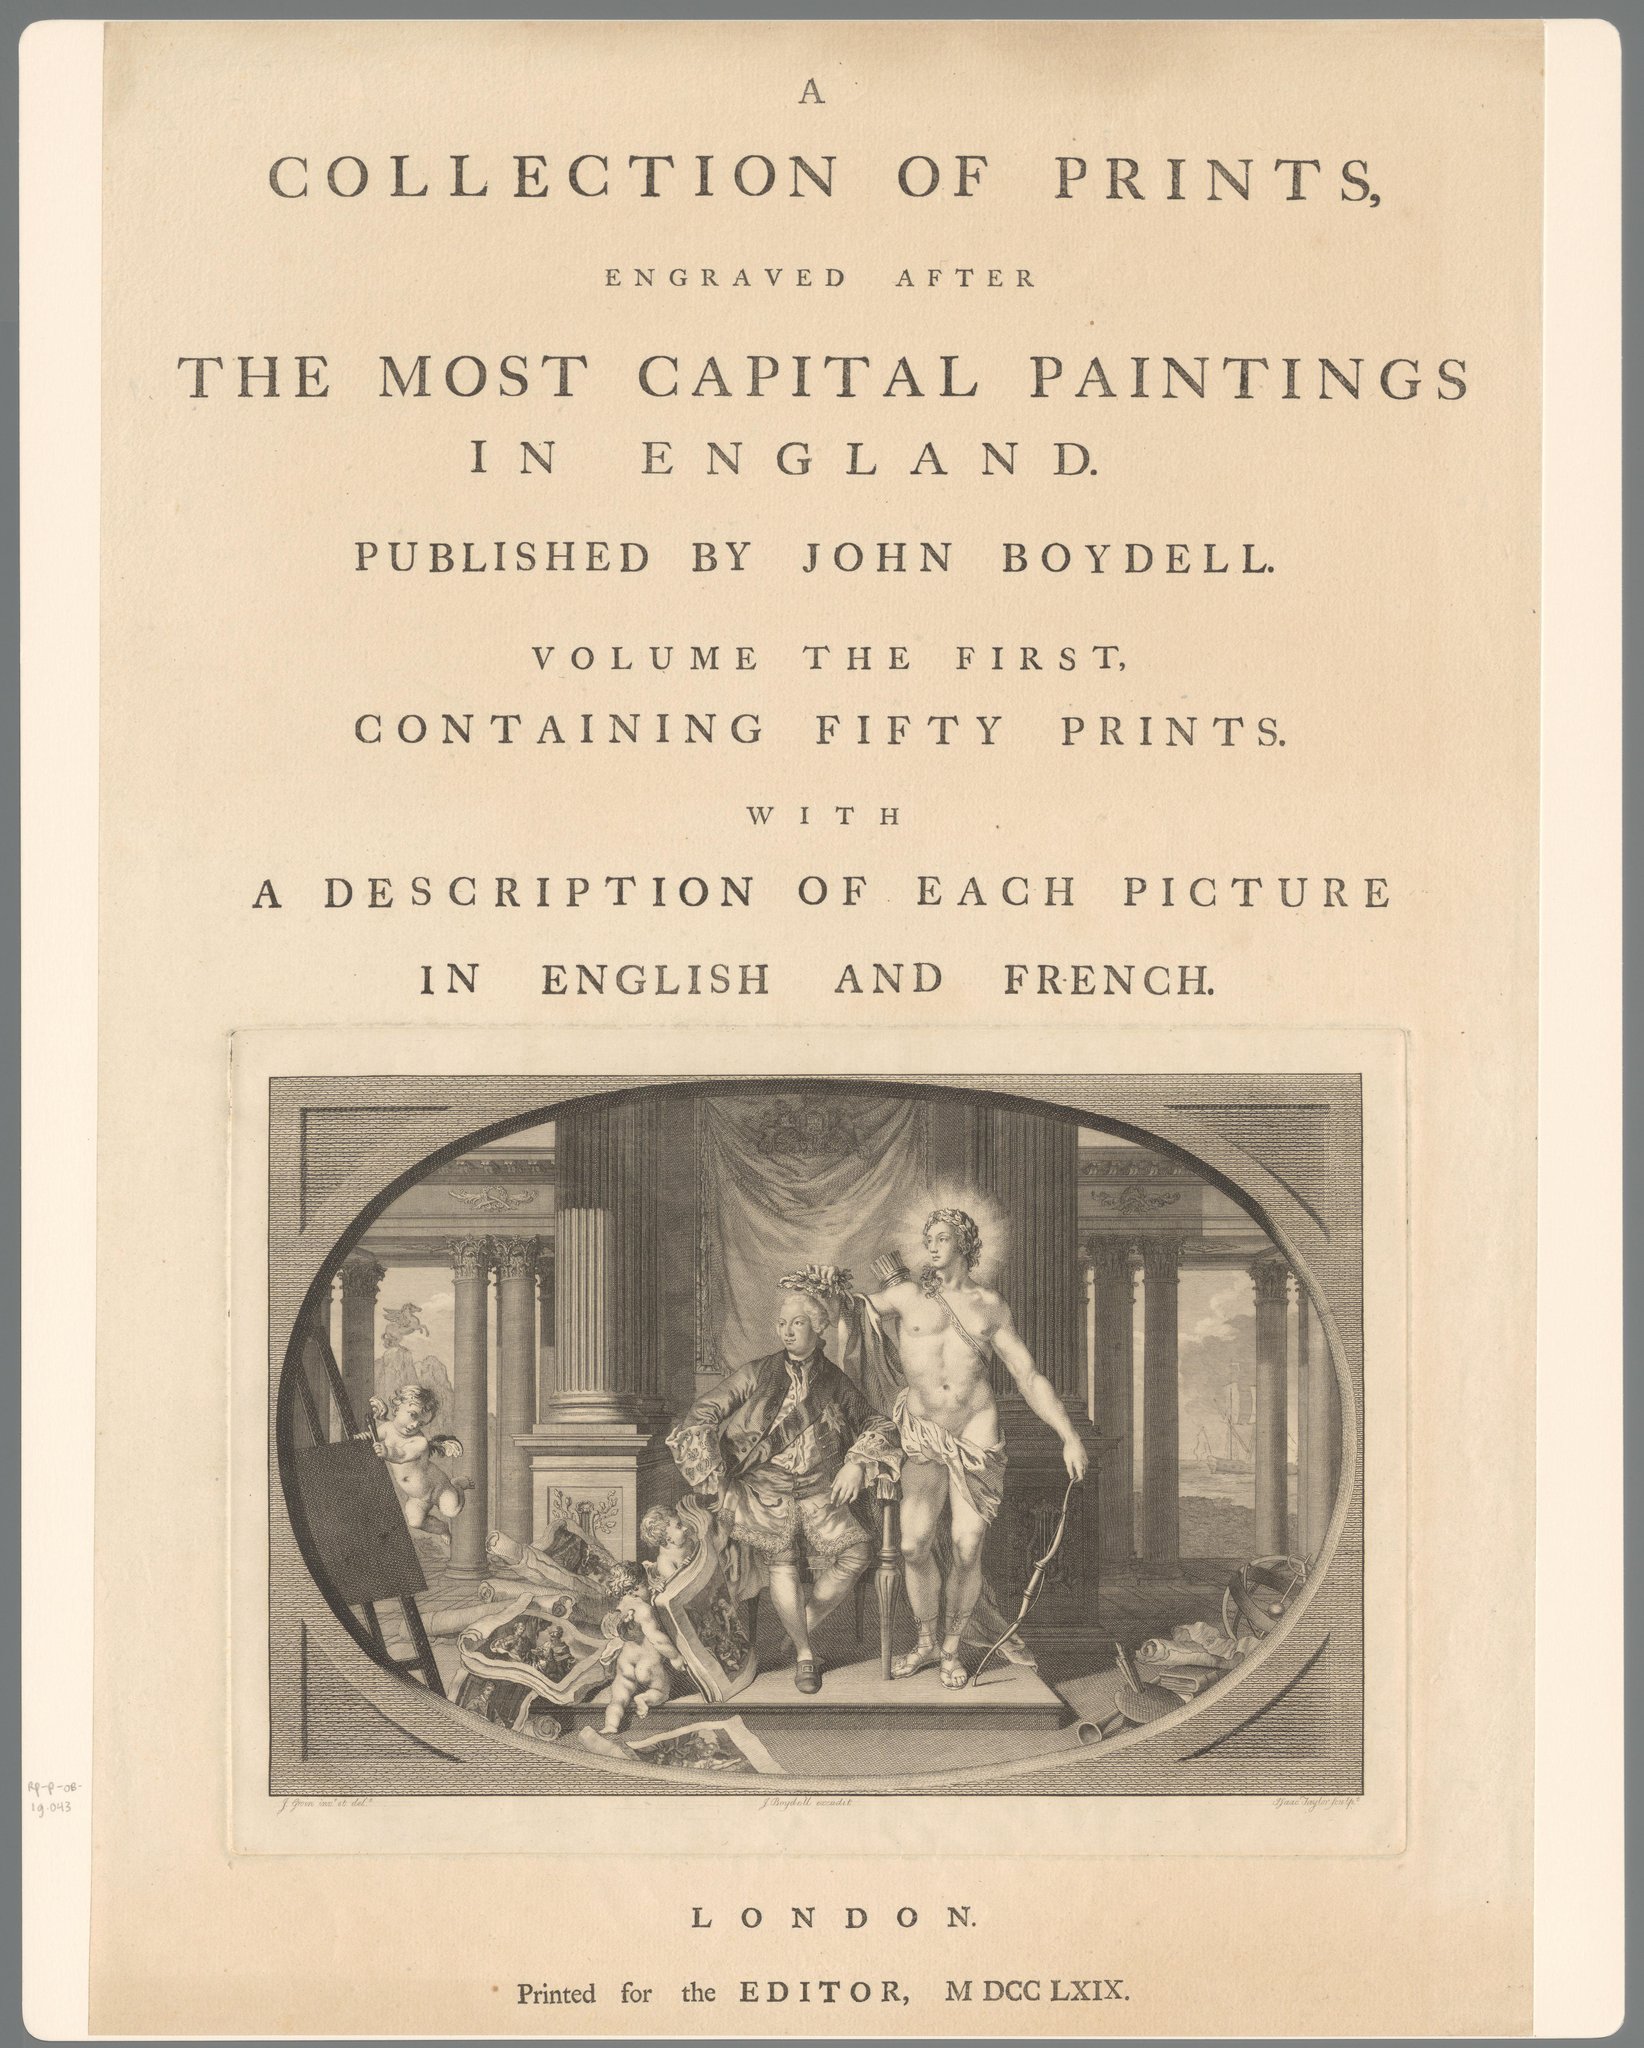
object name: titelblad, titelpagina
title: Voornaamste schilderijen van Engeland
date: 1769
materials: paper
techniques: engraving, etching, letterpress printing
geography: london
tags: column, pillar ~ architecture, (story of) apollo (phoebus), print, e.g.: engraving, etching, lithograph, crowning with laurel, cupids: 'amores', 'amoretti', 'putti'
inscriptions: date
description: Vanaf 1763 tot 1786 publiceerde John Boydell prenten naar schilderijen uit Engelse collecties. Deze waren vanaf 1769 gebonden verkrijgbaar. Dit is de titelpagina voor het eerste deel van de gebonden versie uit 1769. Titelpagina voor: Boydell, John. A collection of Prints, engraved after the Most Capital Paintings in England. Londen: John Boydell, 1769.